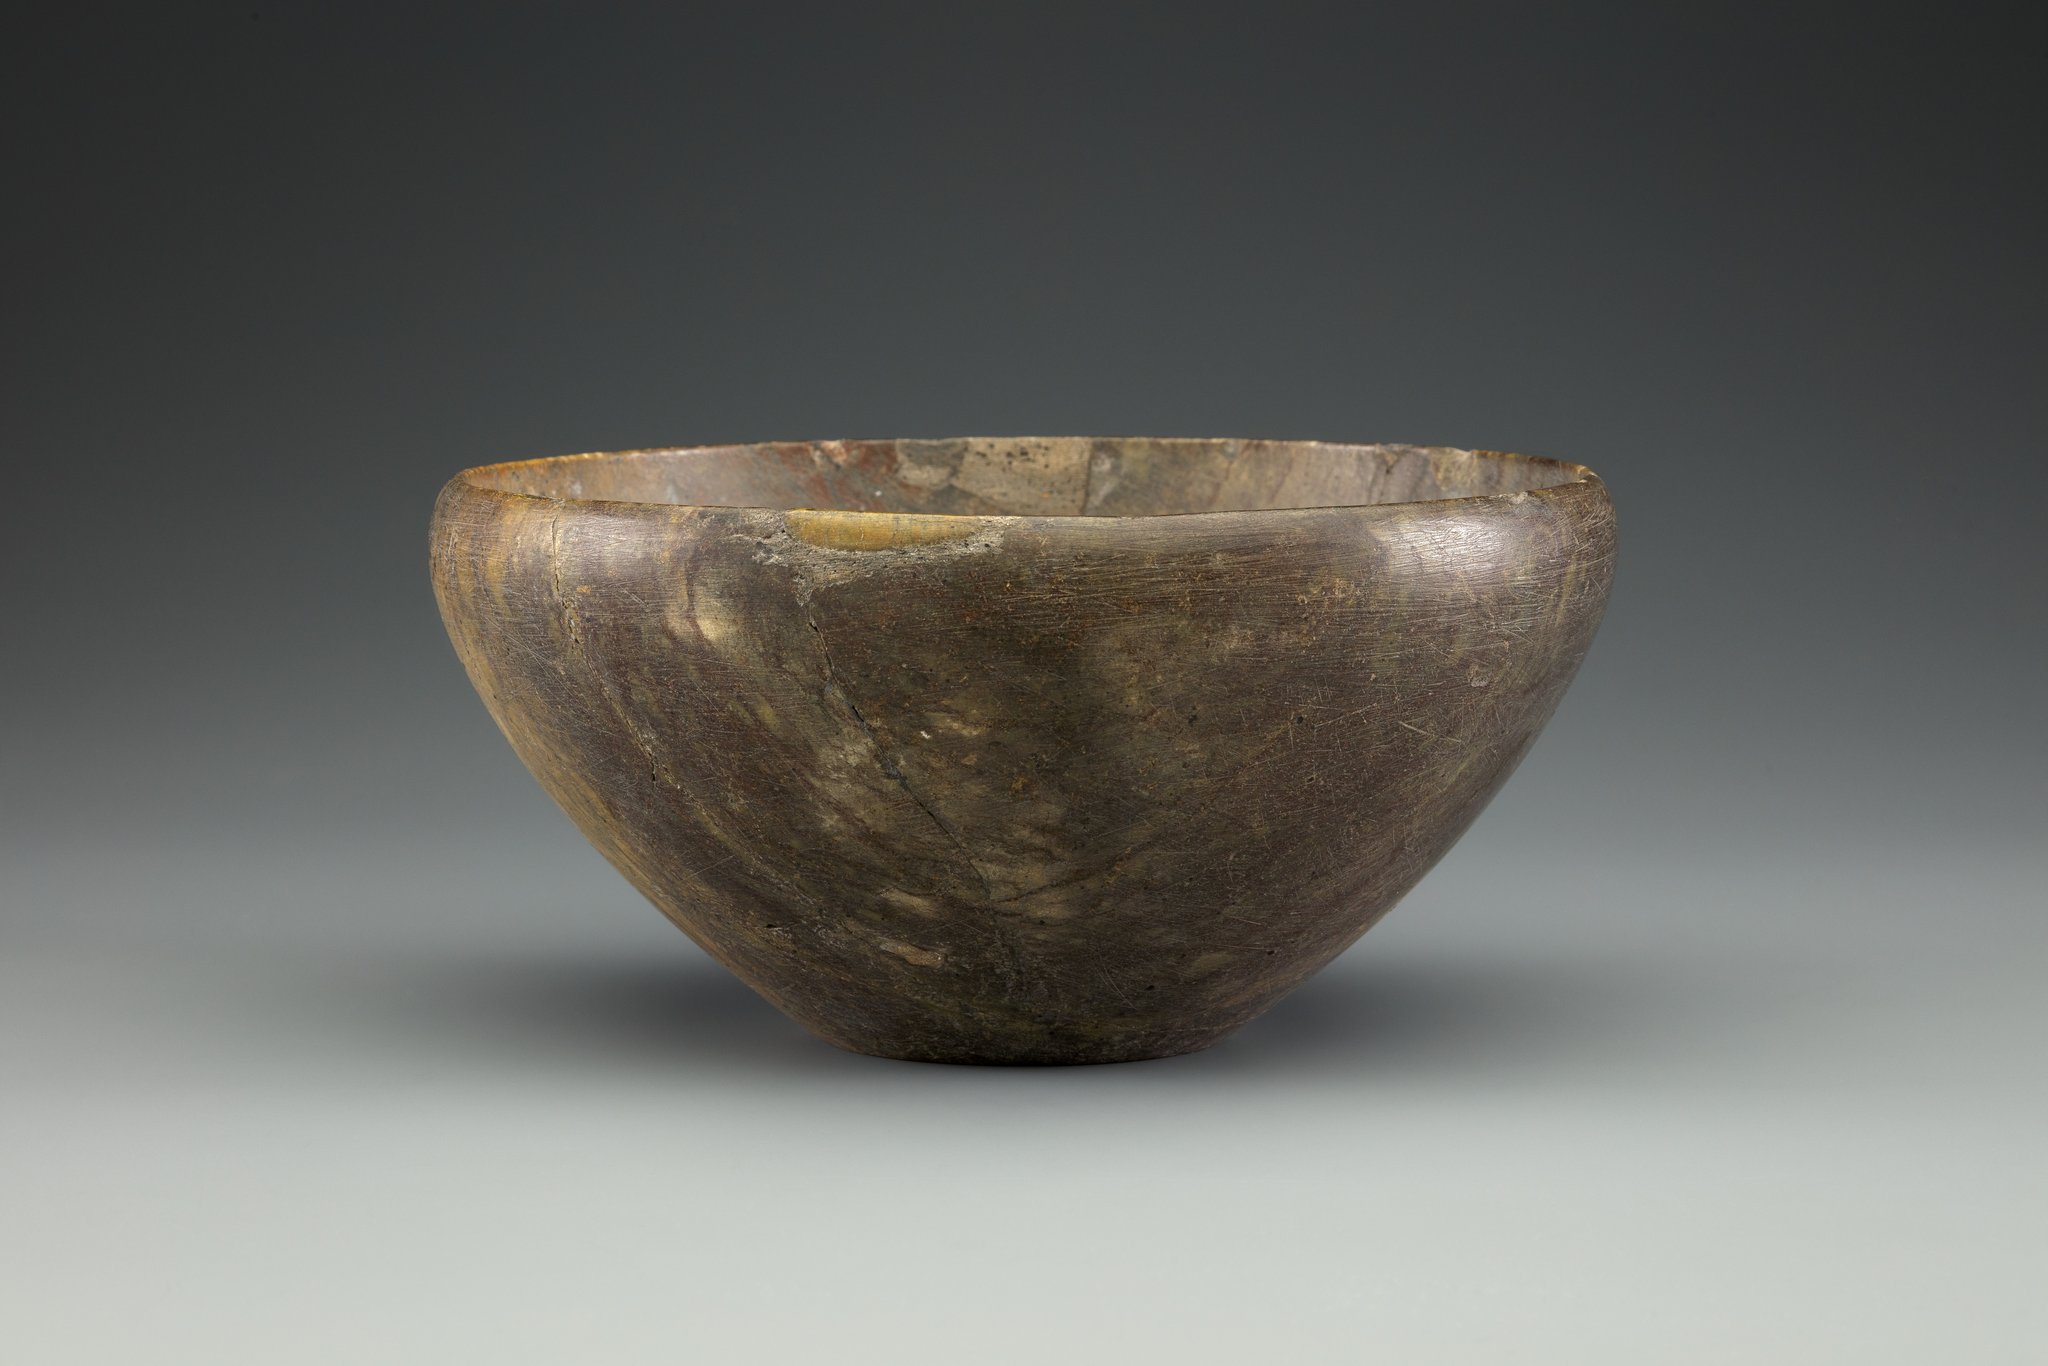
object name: bowl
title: Deep bowl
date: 3100-2649 BCE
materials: stone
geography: egypt